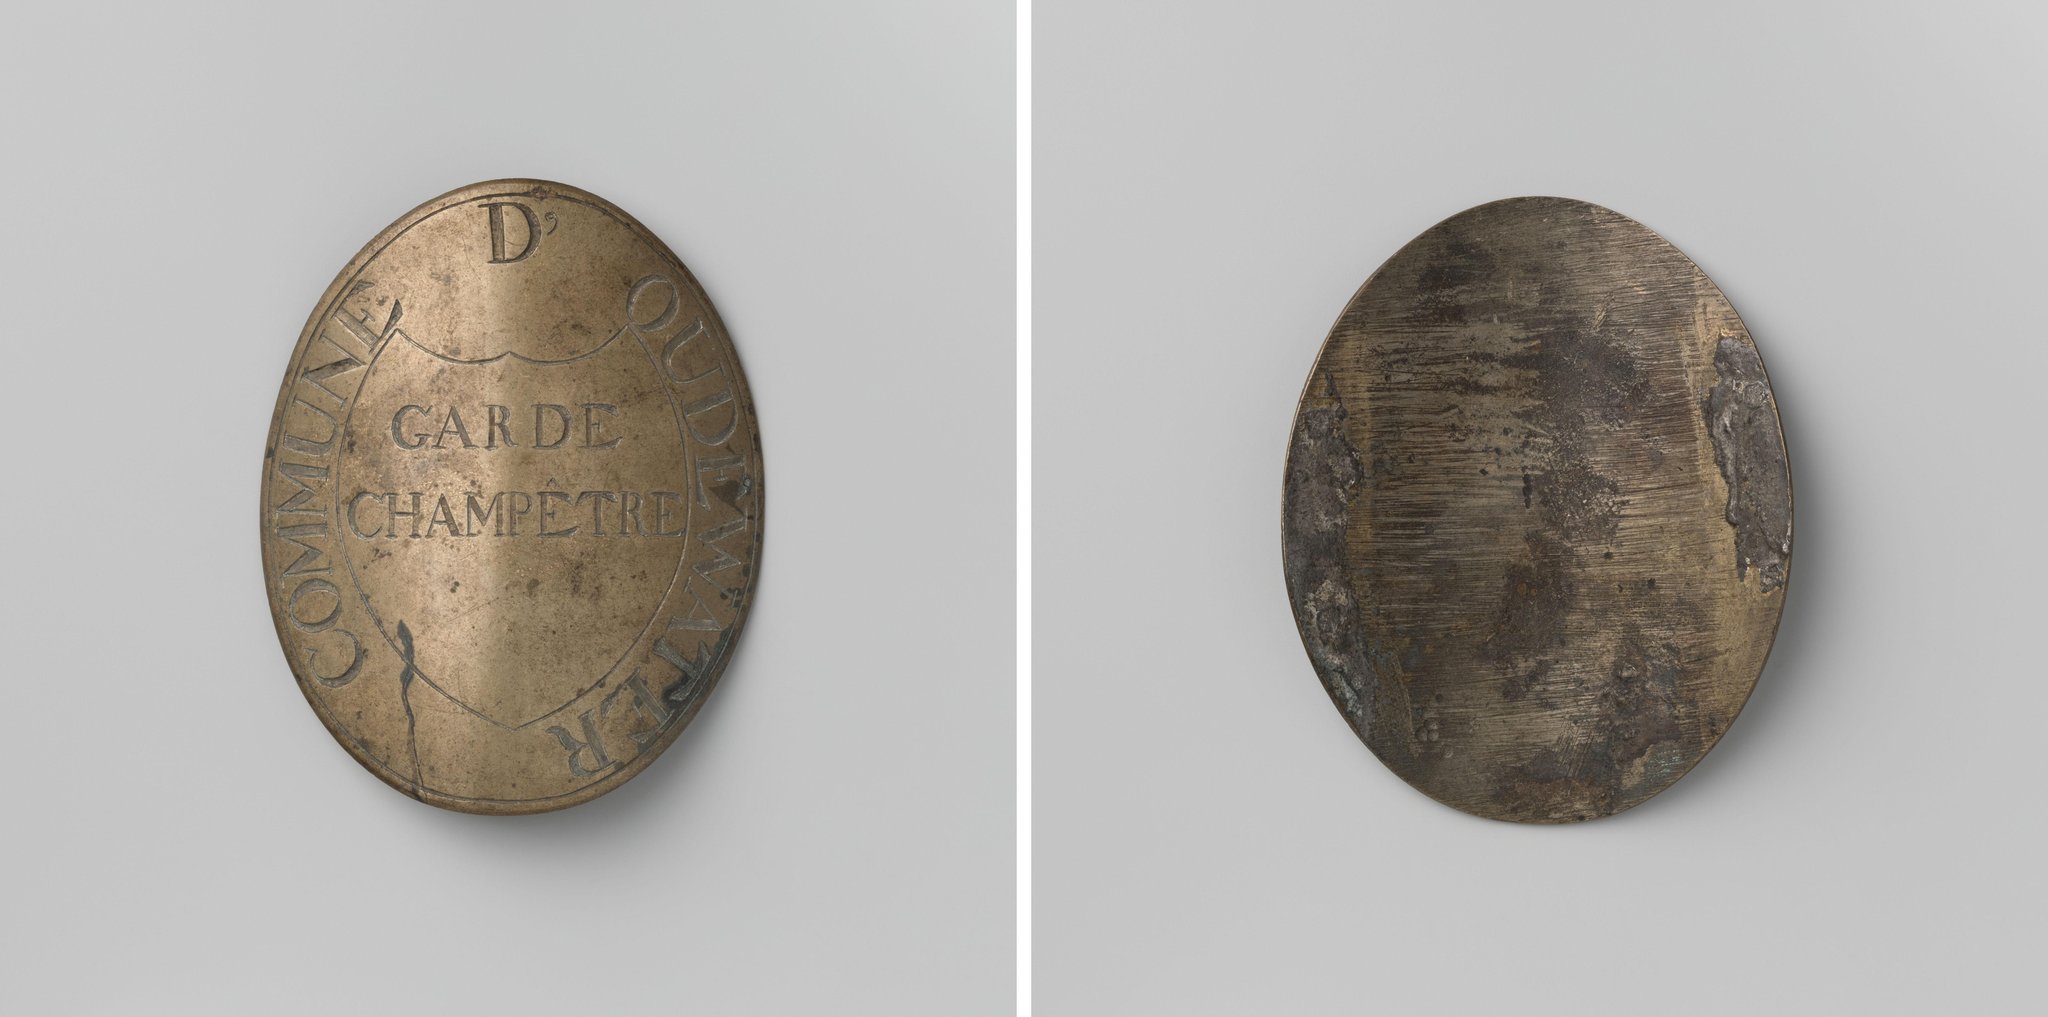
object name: identification medal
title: Garde Champetre van de stad Oudewater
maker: Anonymous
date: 1810-1814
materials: brass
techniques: engraving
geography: netherlands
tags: oudewater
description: Eenzijdige messing ovale, bolle penning met op keerzijde vier aanhechtingspunten. Voorzijde: wapenschild met opschrift binnen omschrift. Keerzijde: blanco.